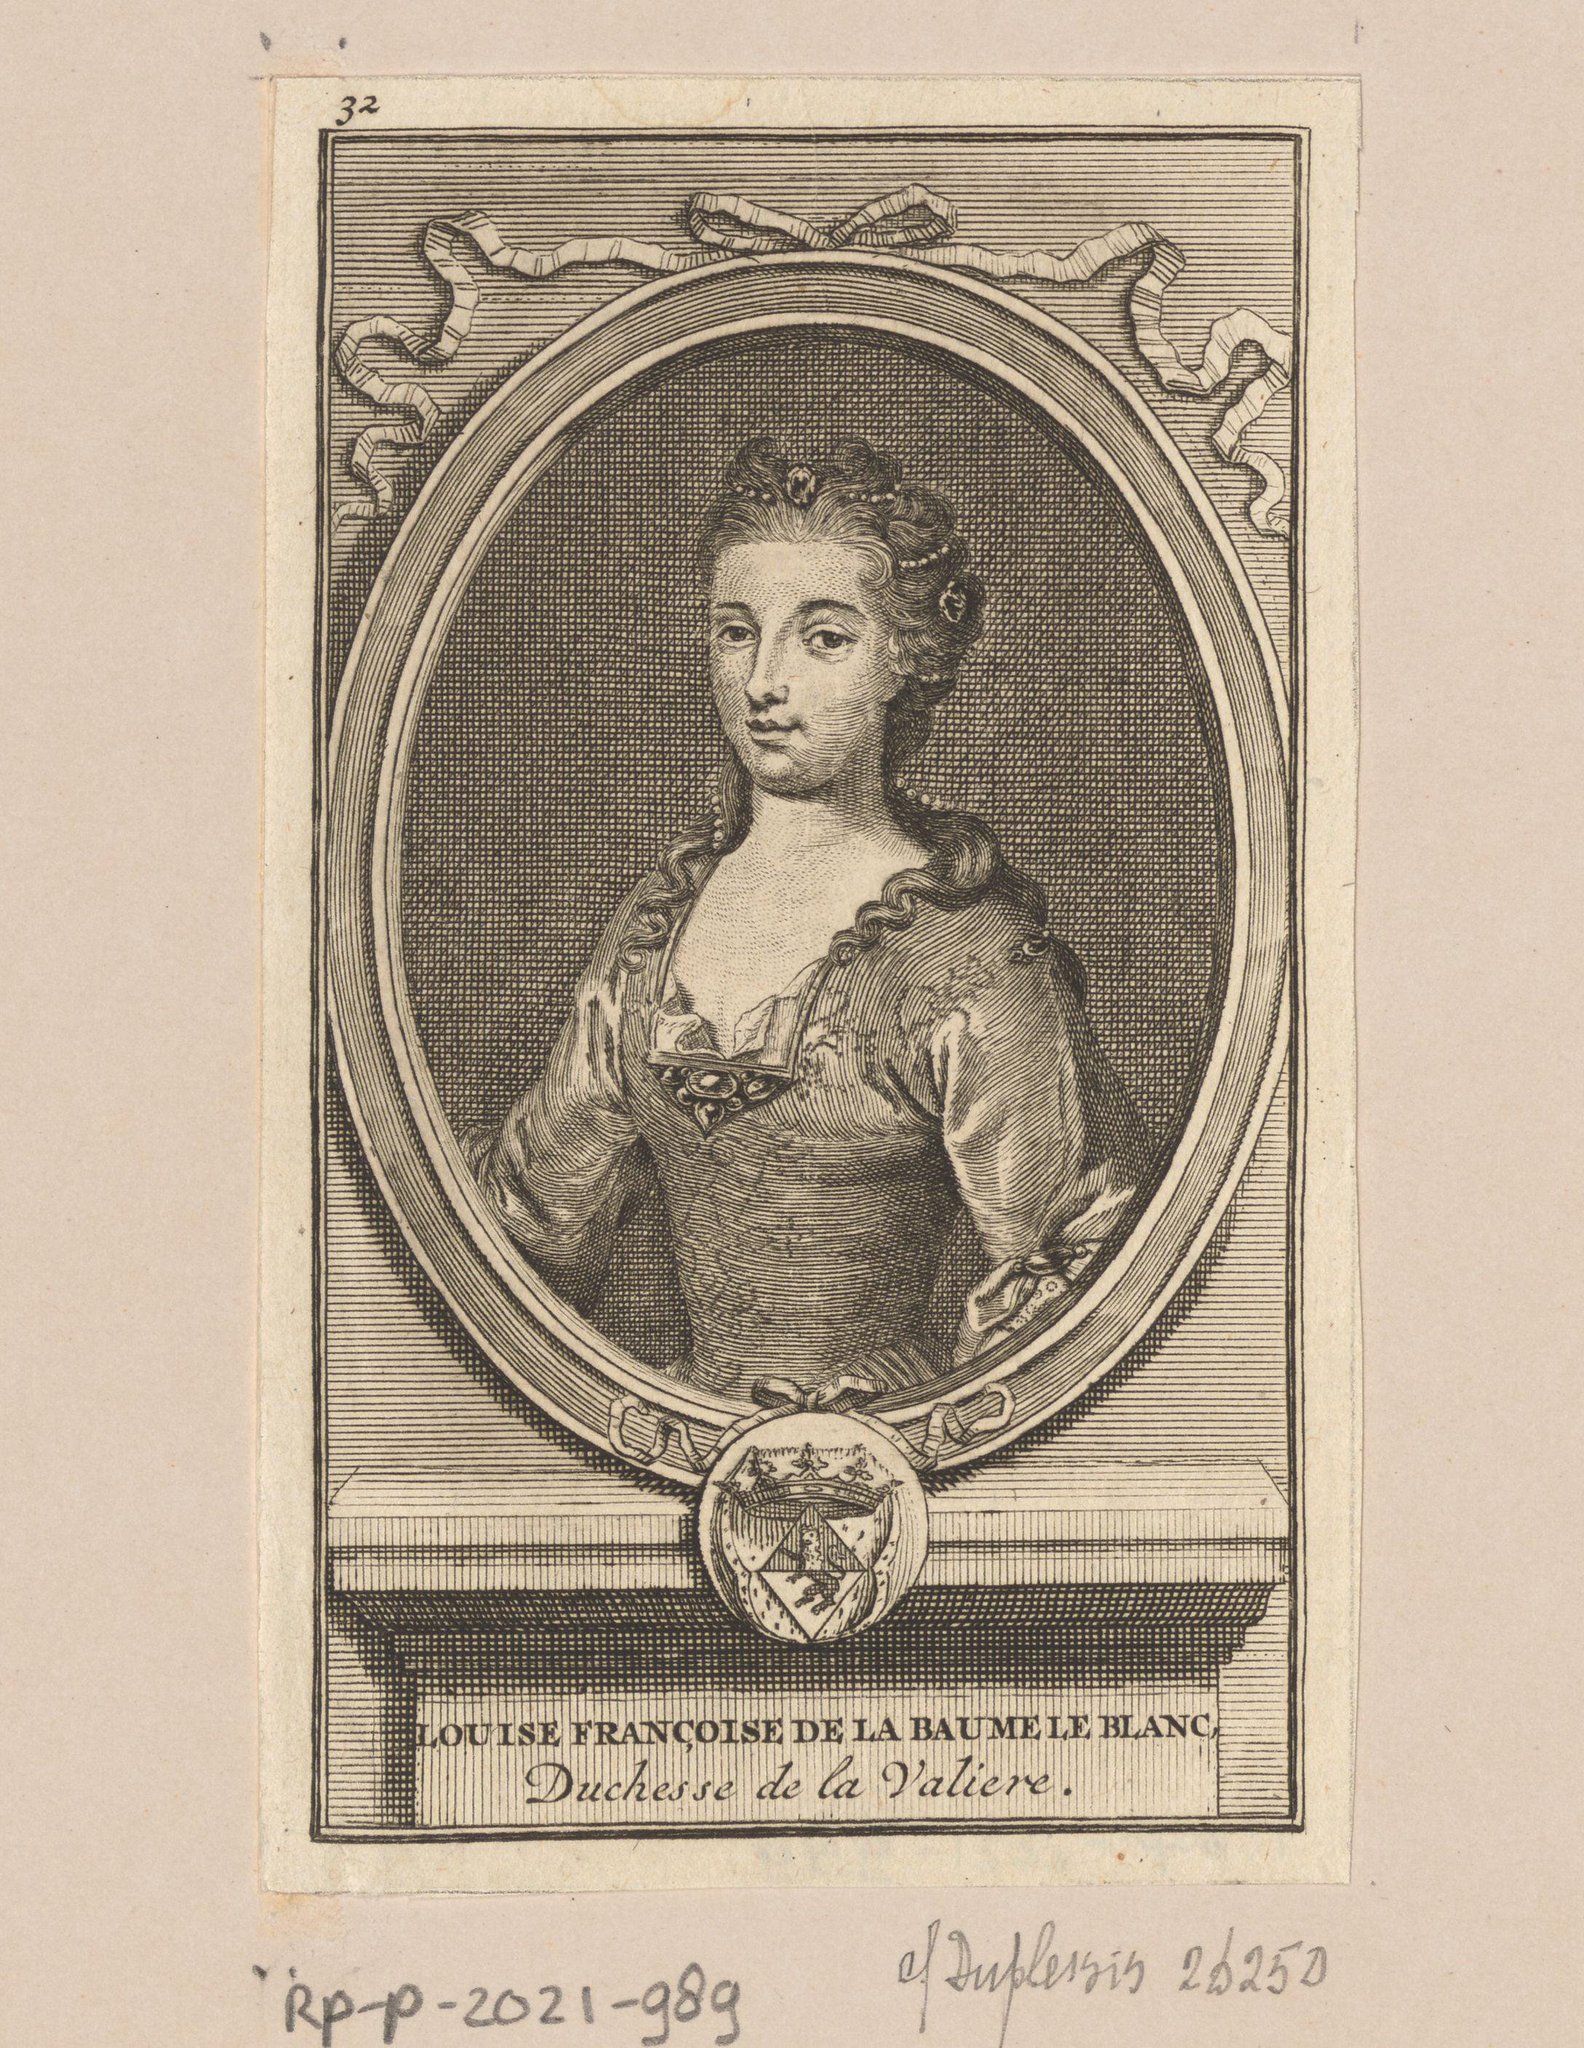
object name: print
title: Portret van Louise de La Vallière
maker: Anonymous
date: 1718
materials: paper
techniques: etching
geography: northern netherlands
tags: paris, historical persons - bb - woman, ornament ~ medallion, armorial bearing, heraldry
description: Prent waarschijnlijk uit: Limiers, Henri Philippe de. Historie der regeringe van Lodewyk den XIV (...). Amsterdam: Compagnie, 1718.